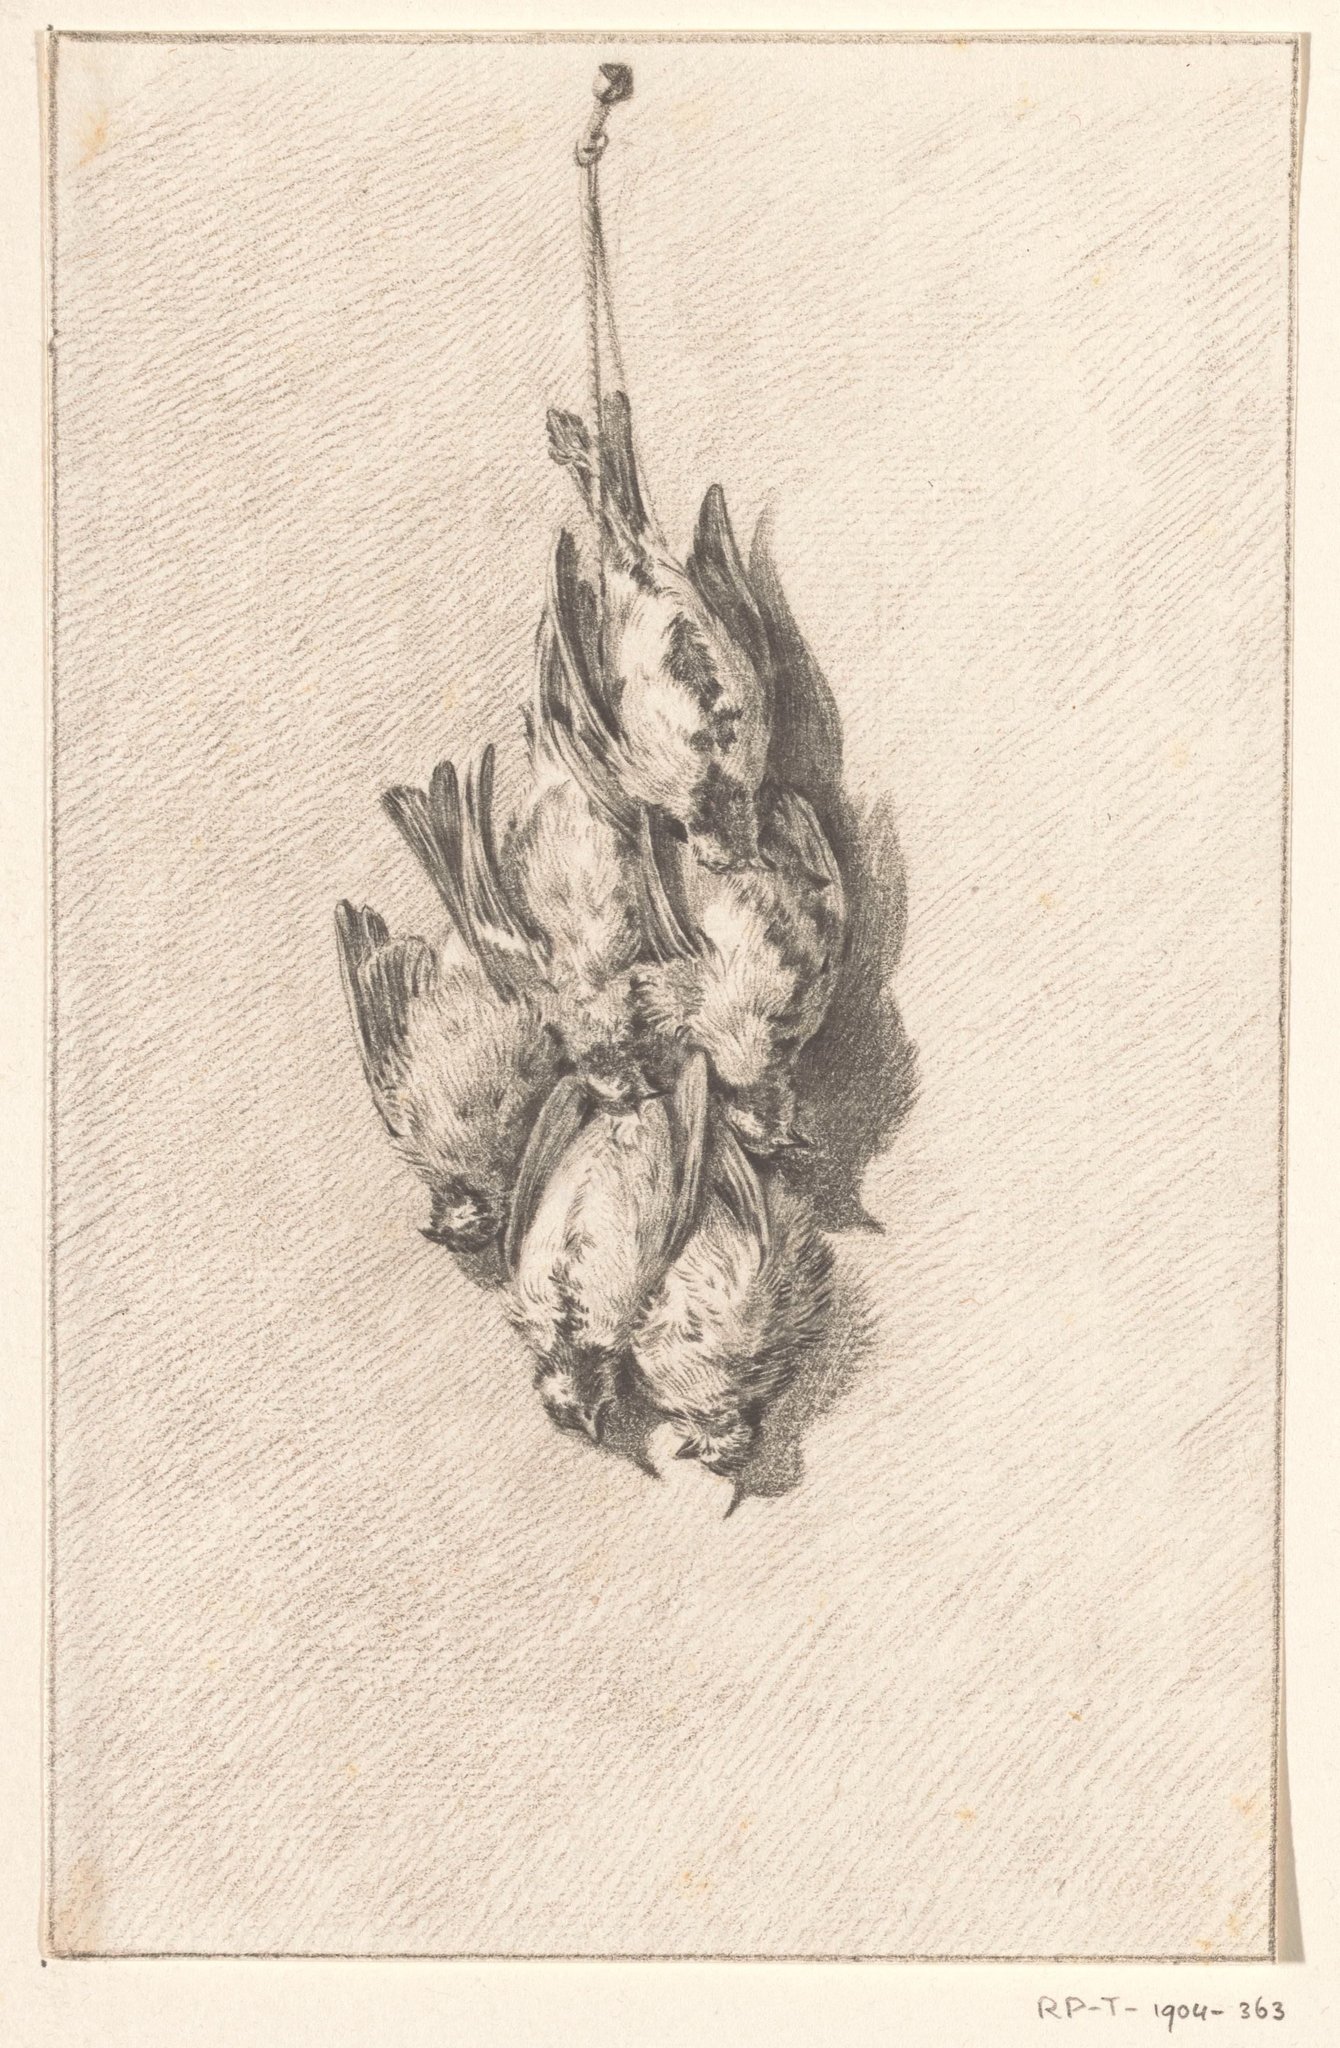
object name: drawing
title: Zes dode vogeltjes aan een touw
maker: jean bernard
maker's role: draughtsman, print maker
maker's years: 1765-1833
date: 1775-1833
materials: chalk, paper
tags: birds (+ animal killed by man)